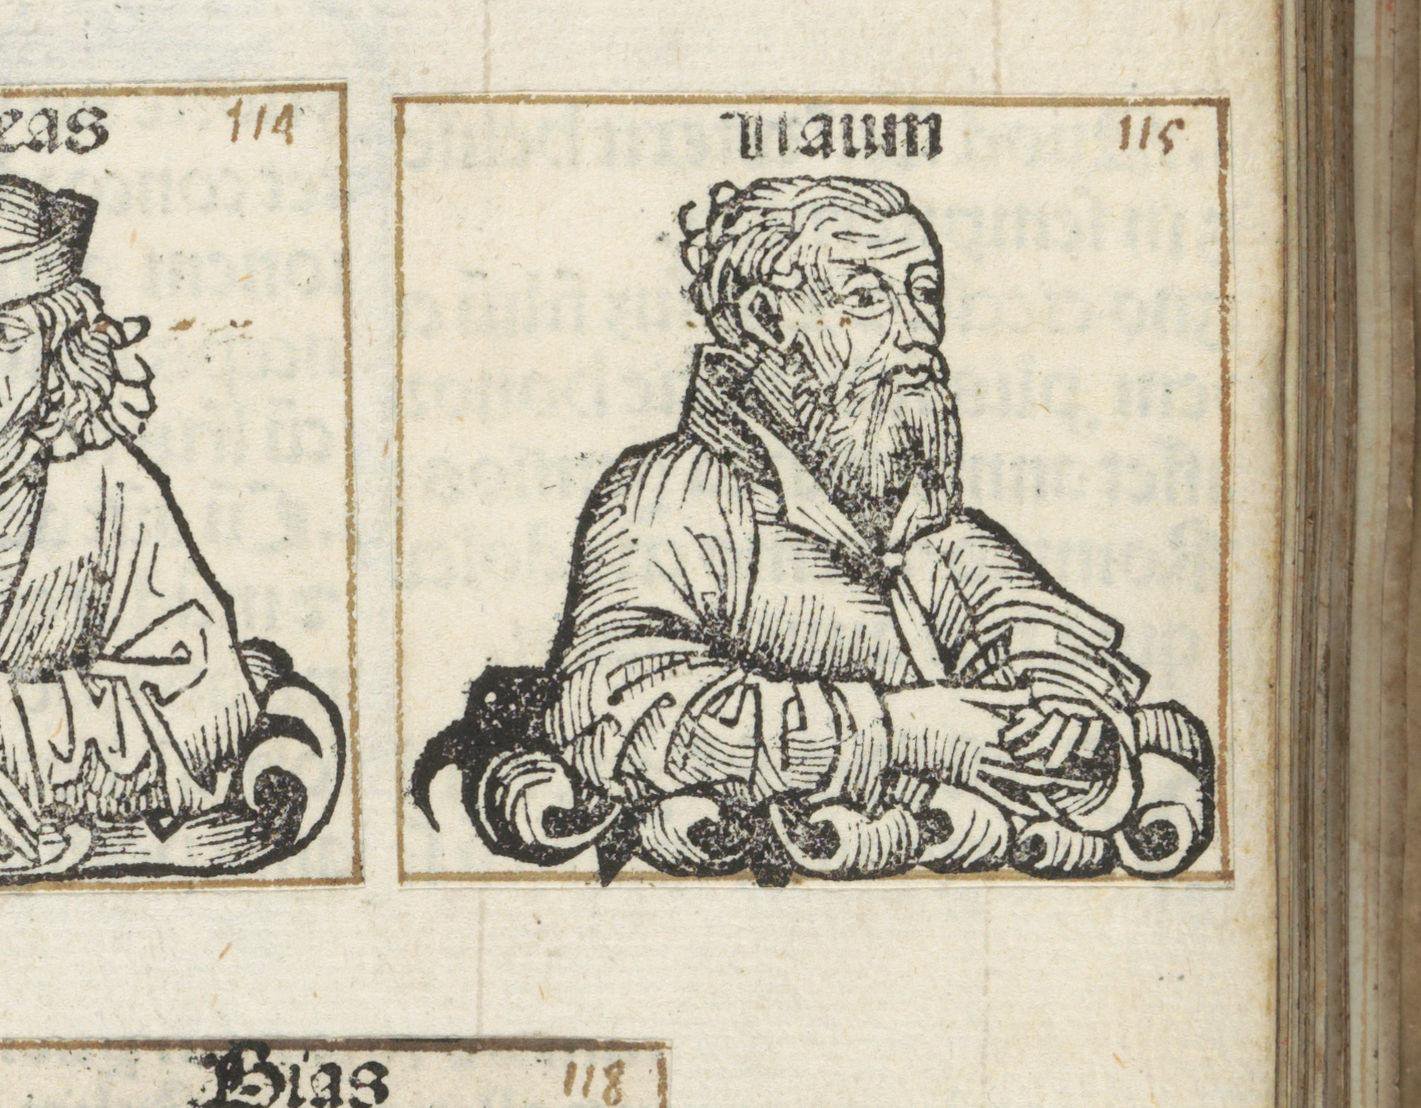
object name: book illustration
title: Nahum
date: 1493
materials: paper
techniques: letterpress printing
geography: nuremberg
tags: persons from the old testament (not in biblical context, nor occurring in legendary/historical extensions included in division 71)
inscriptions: inscription: ‘115’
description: Een bloemkelk met een bebaarde man, naar rechts gekeerd. De voorstelling is een fragment van de lijn van de profeten van Israël in de Liber Chronicarum. De tekst identificeert hem als de profeet Nahum. De prent maakt deel uit van een album.